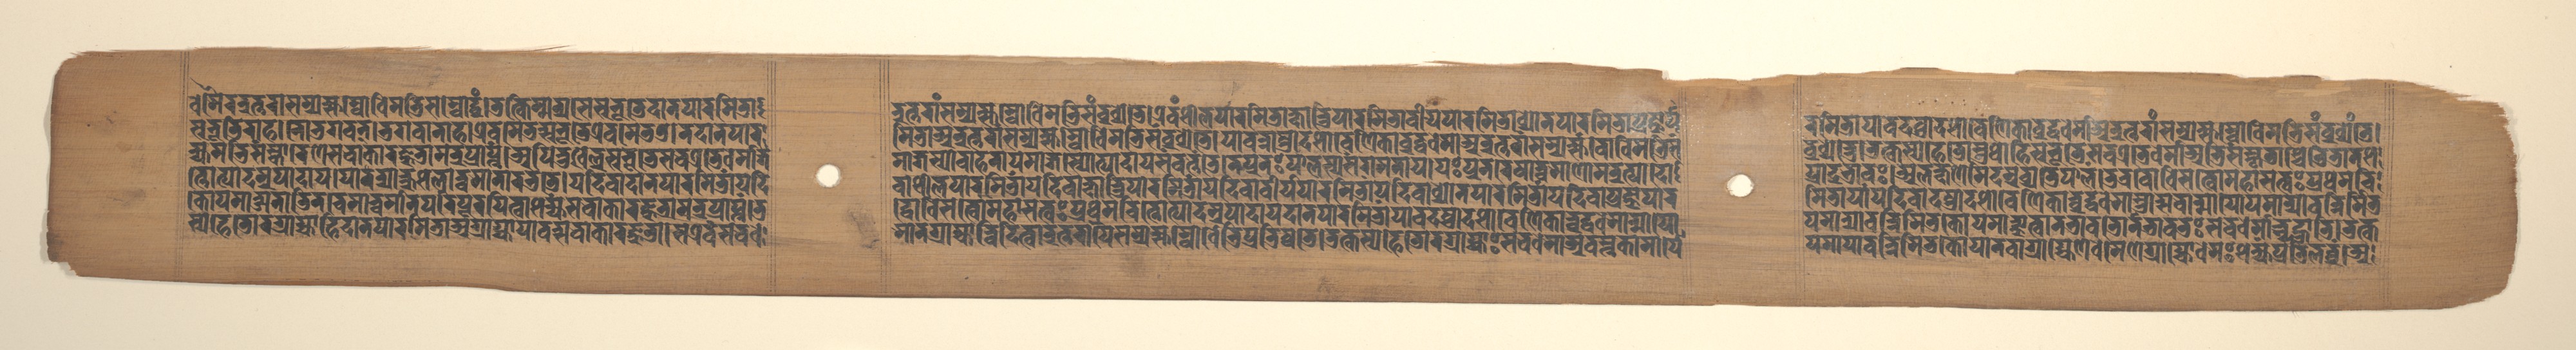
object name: folio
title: Folio from a Buddhist Manuscript of Pancavimsatisahasrika Prajnaparamita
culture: indian, bengal or bangladesh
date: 1090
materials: leaf, watercolor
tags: buddhism